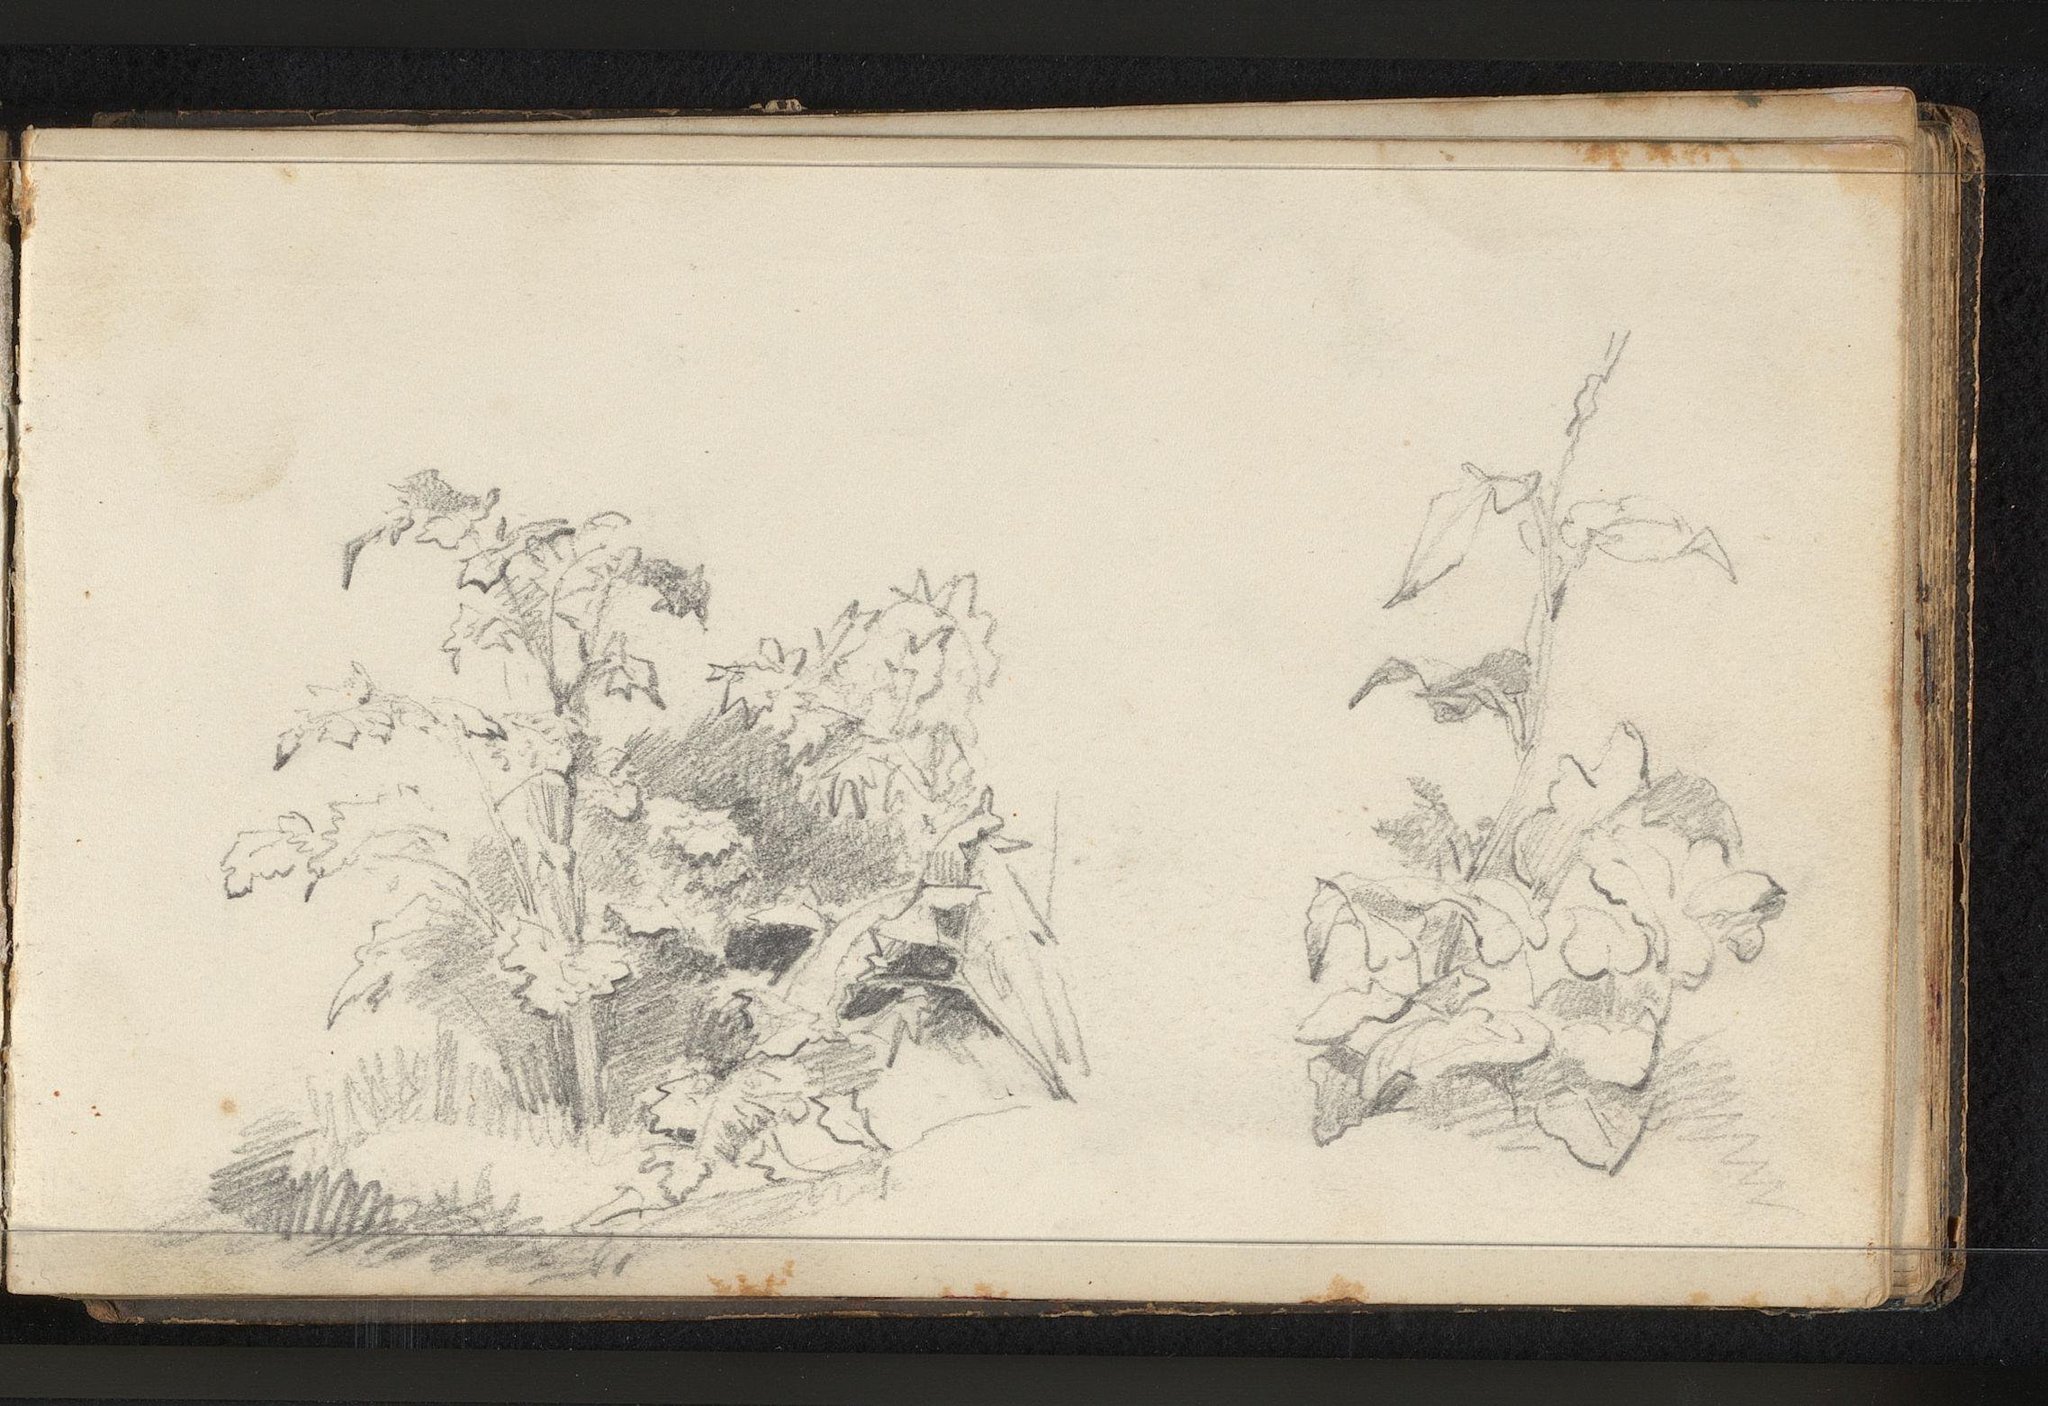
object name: sketchbook leaf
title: planten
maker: jan bedijs tom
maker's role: draughtsman, painter, print maker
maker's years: 1813-1894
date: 1828-1894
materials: paper, pencil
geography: the hague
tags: plants; vegetation, artist (in general) making preliminary designs, sketching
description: Pagina 27 verso uit een schetsboek met 54 bladen.